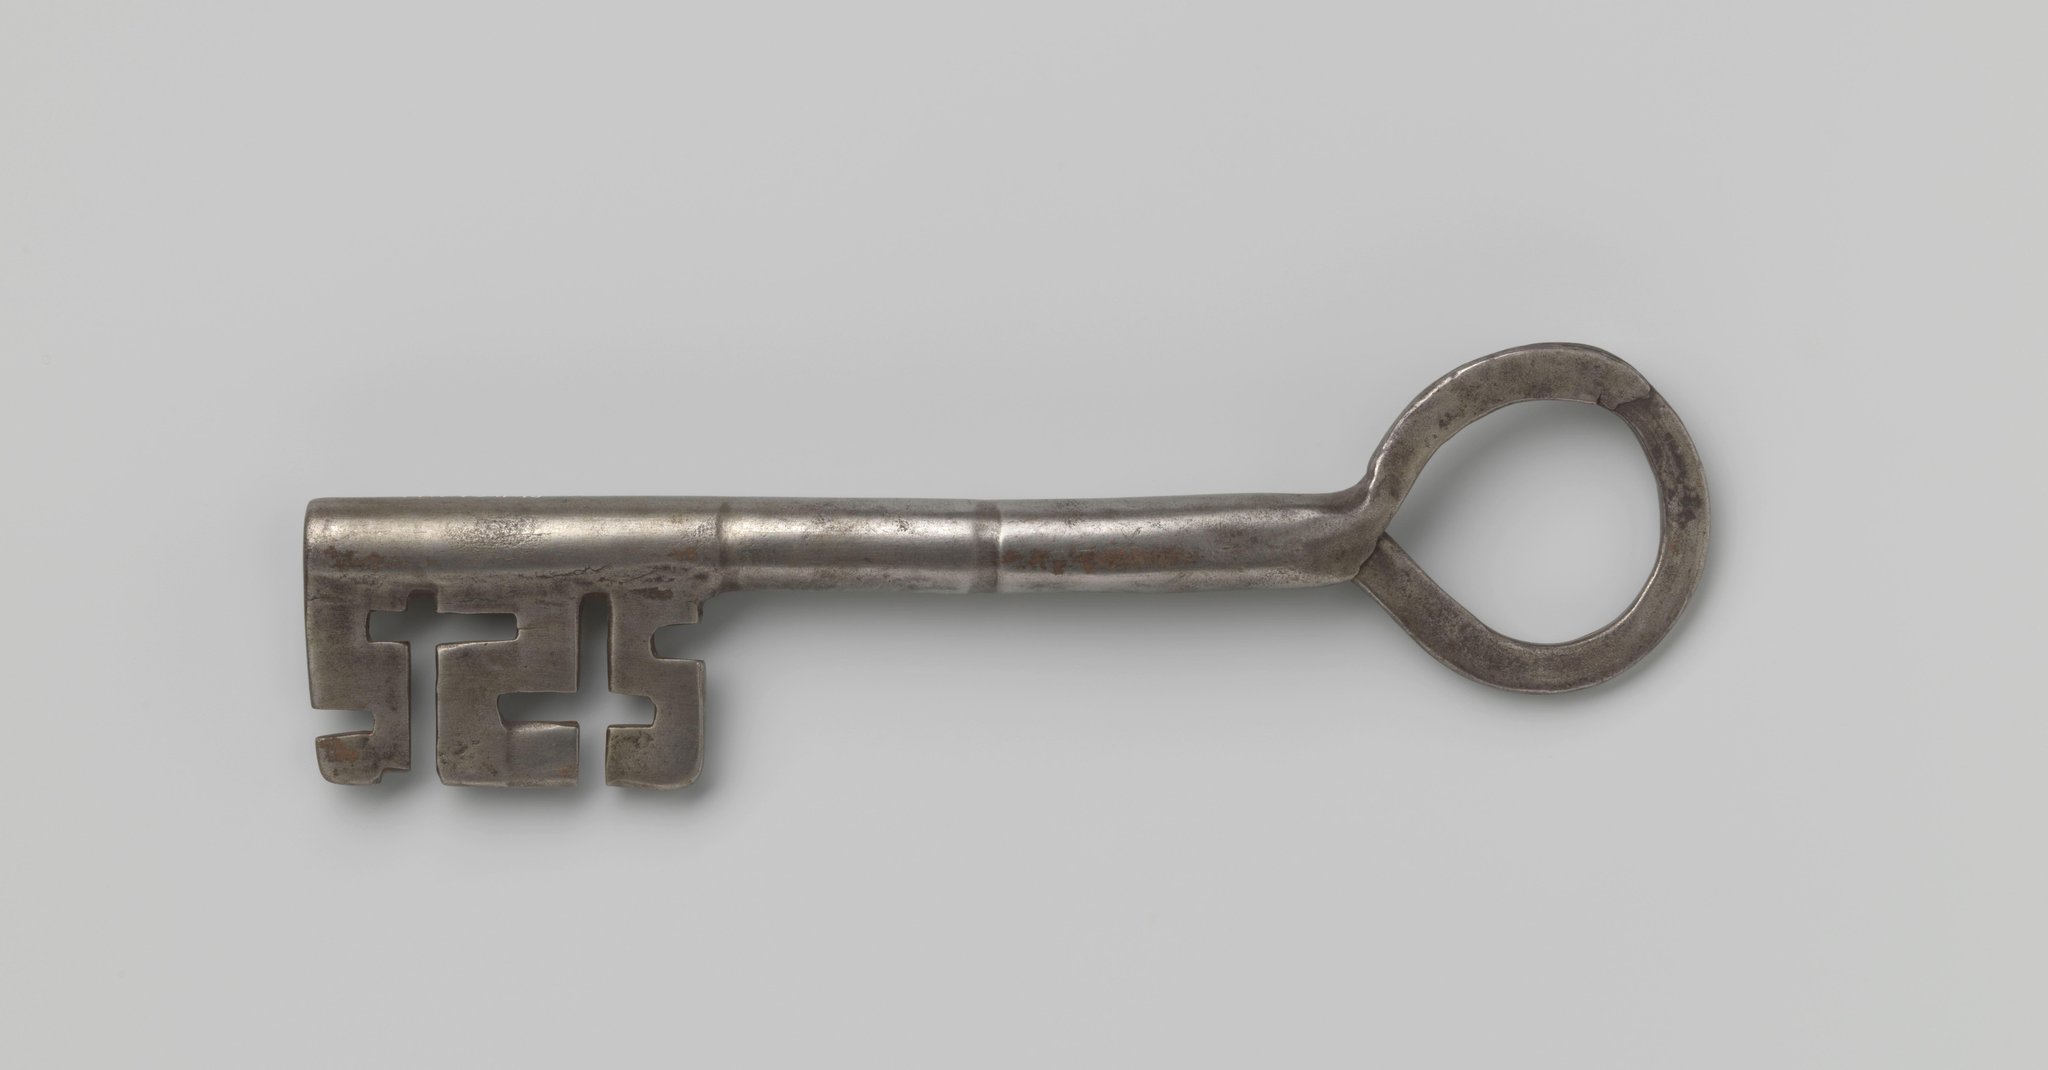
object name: pipe key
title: Pijpsleutel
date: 1300-1500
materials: iron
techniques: forging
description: Pijpsleutel met rond oog; uit een stuk gesmeed.